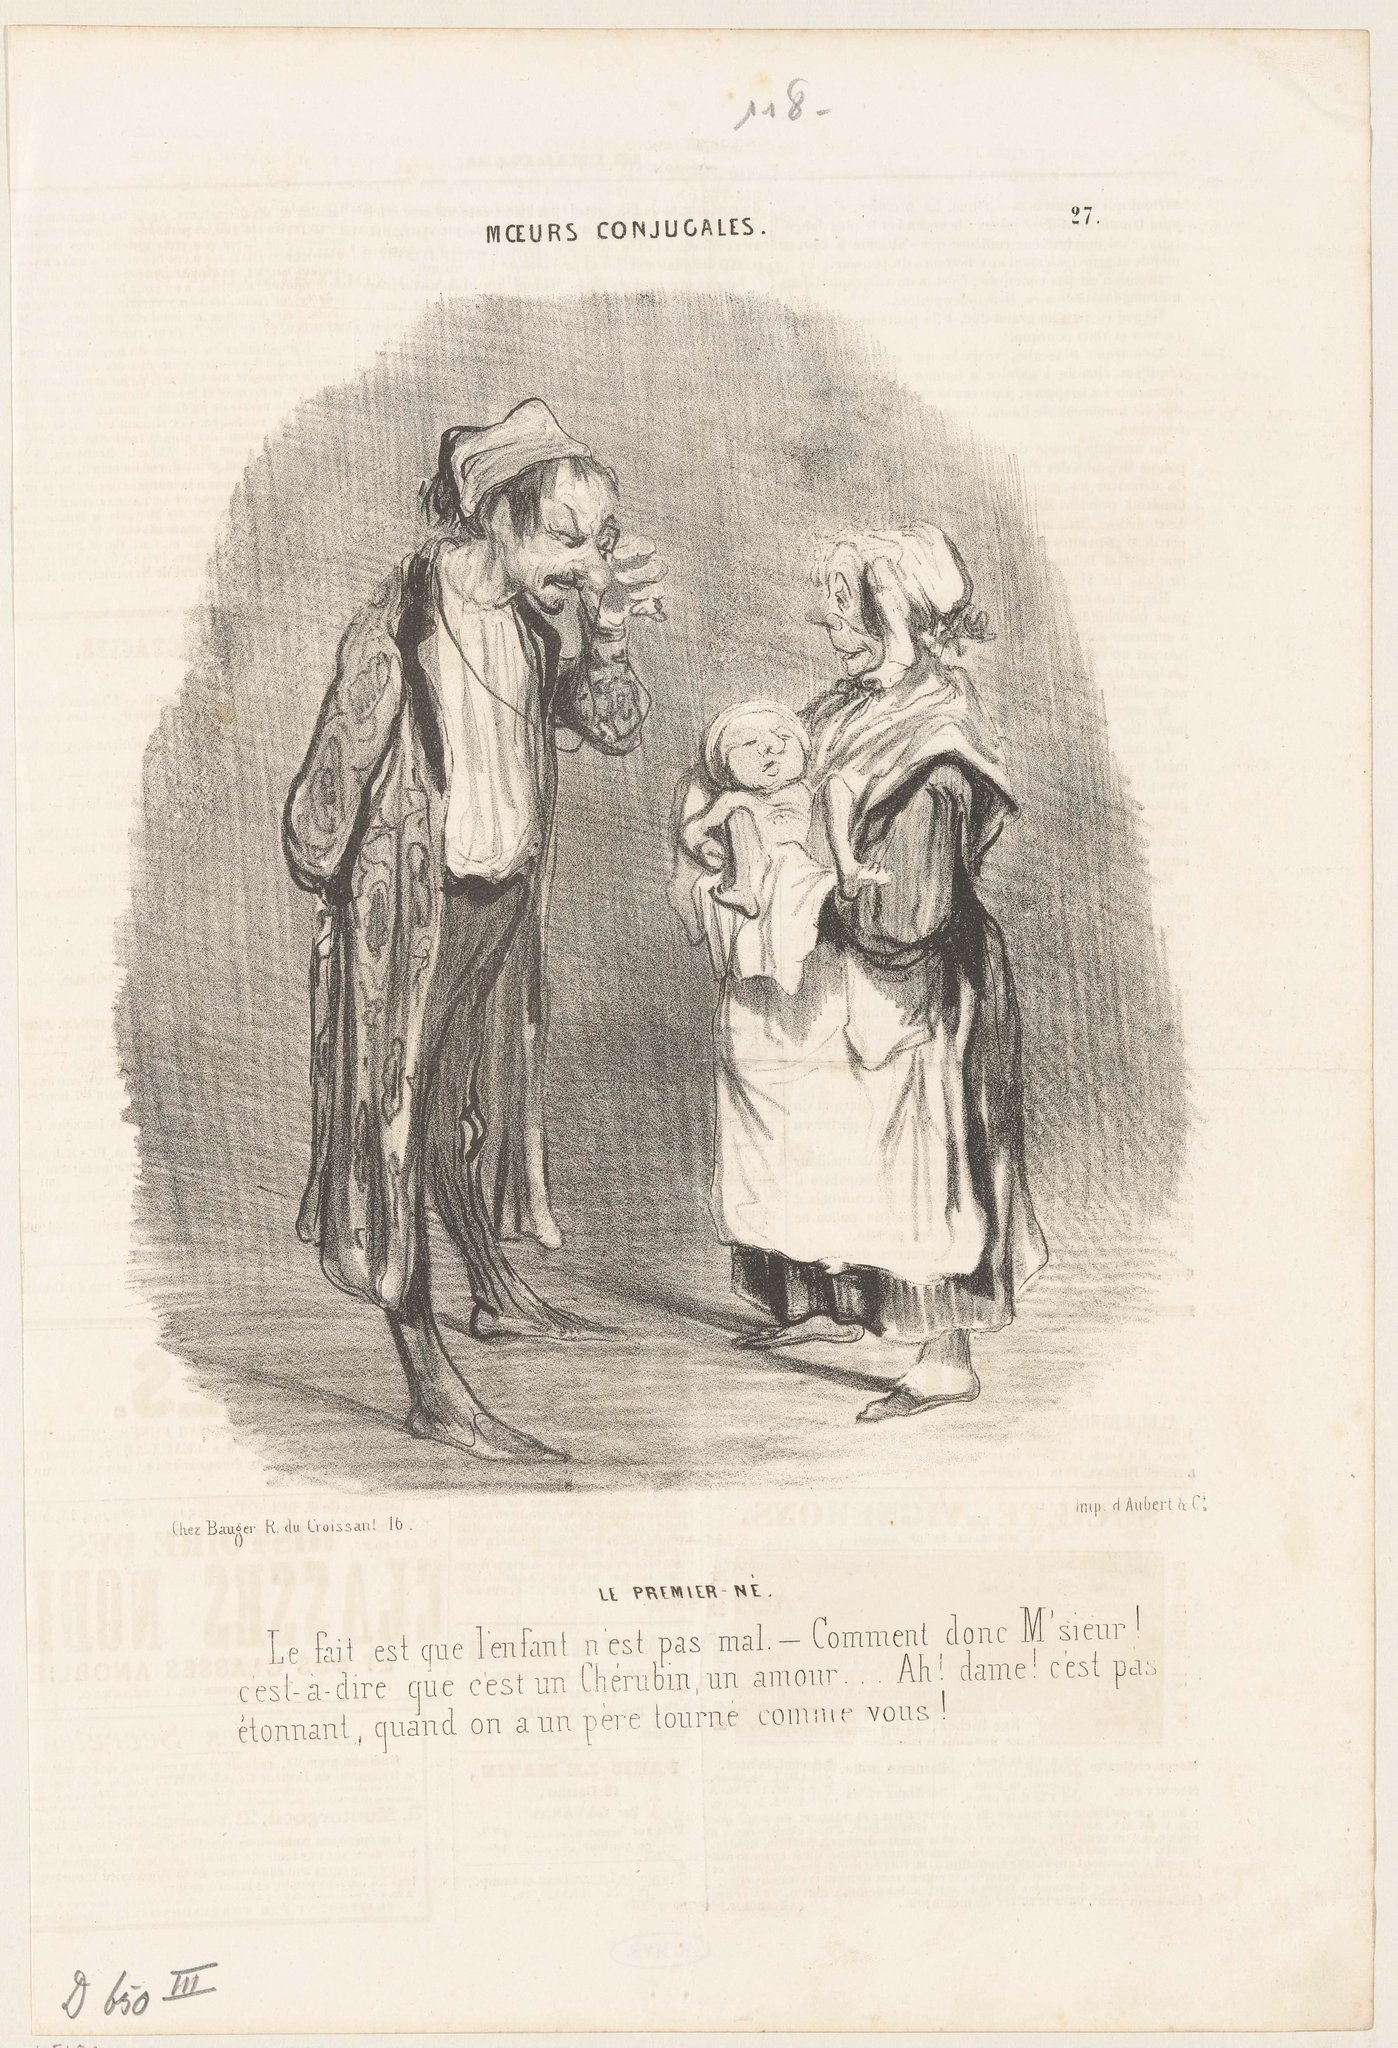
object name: cartoon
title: Vroedvrouw toont een man zijn eerstgeboren kind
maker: honoré daumier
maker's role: draughtsman, painter, print maker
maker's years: 1808-1879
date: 1840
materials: paper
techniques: letterpress printing, lithograph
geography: paris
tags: the new-born child shown to the father, caricatures (human types)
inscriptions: collector's mark: Lugt 2228a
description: Prent mogelijk uit: Le Charivari, 23 augustus 1840.